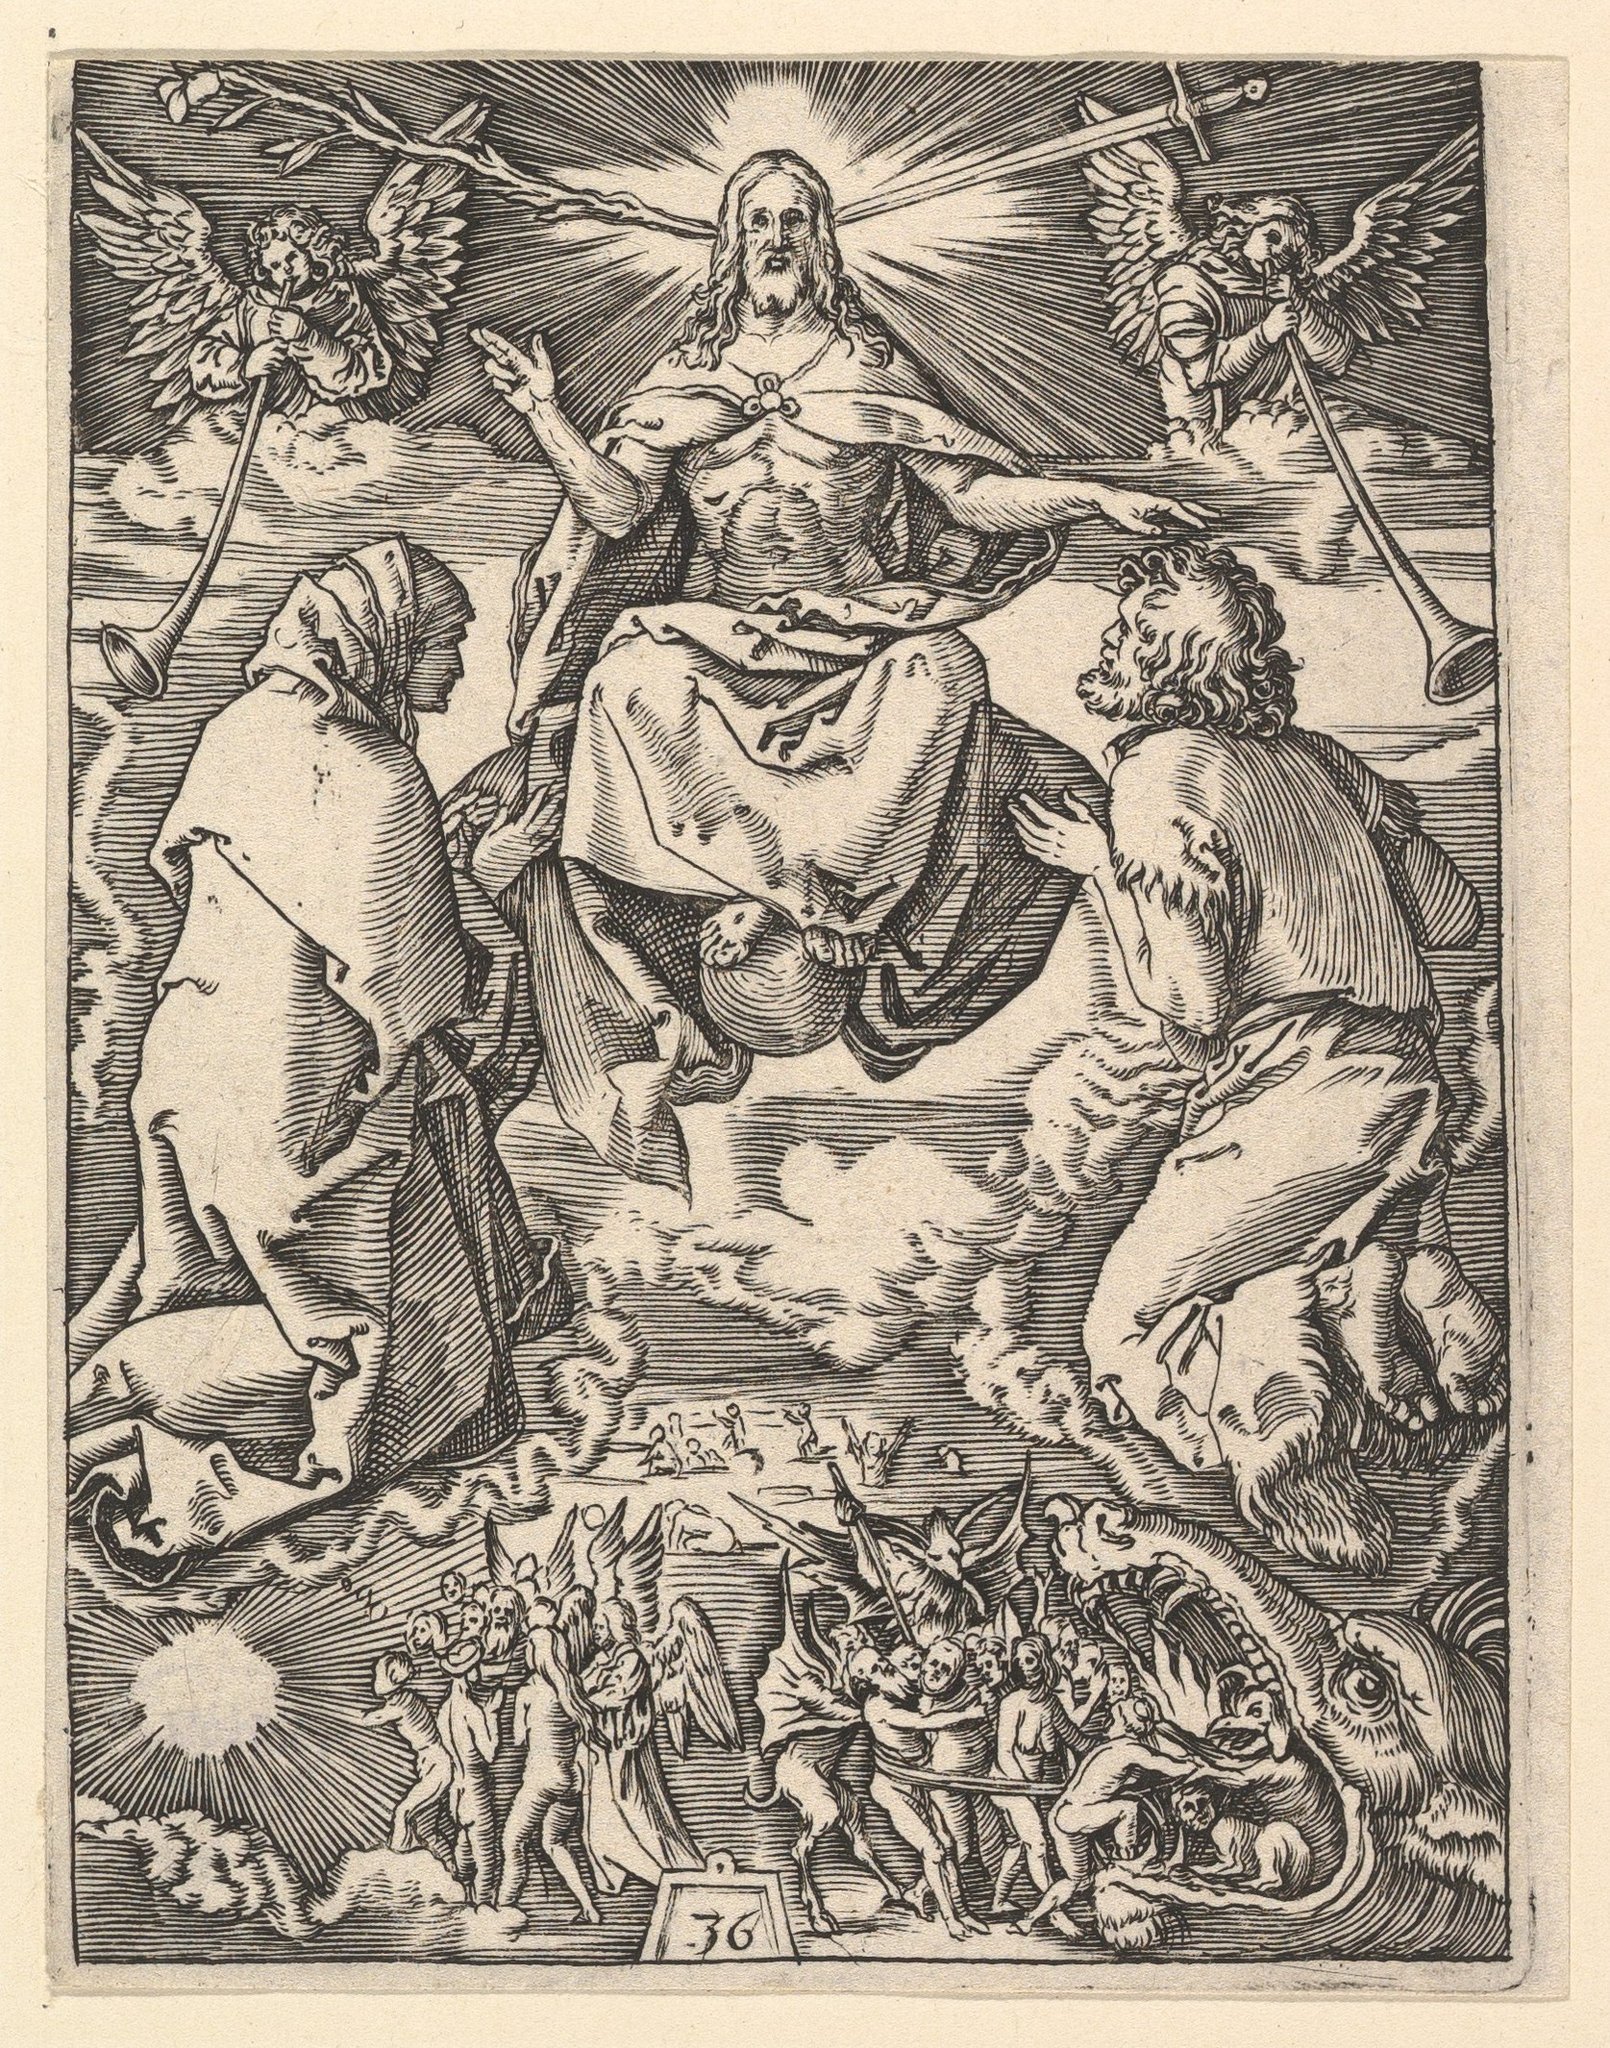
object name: print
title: The Last Judgment; Christ with lily and sword at top, flanked by Virgin and St John the Baptist interceeding on behalf of the humans below, from "The Passion of Christ", after Dürer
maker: marcantonio raimondi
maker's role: artist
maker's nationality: italian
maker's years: 1475-1534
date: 1500-1534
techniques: engraving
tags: swords,lilies,christ,saint john the baptist,virgin mary